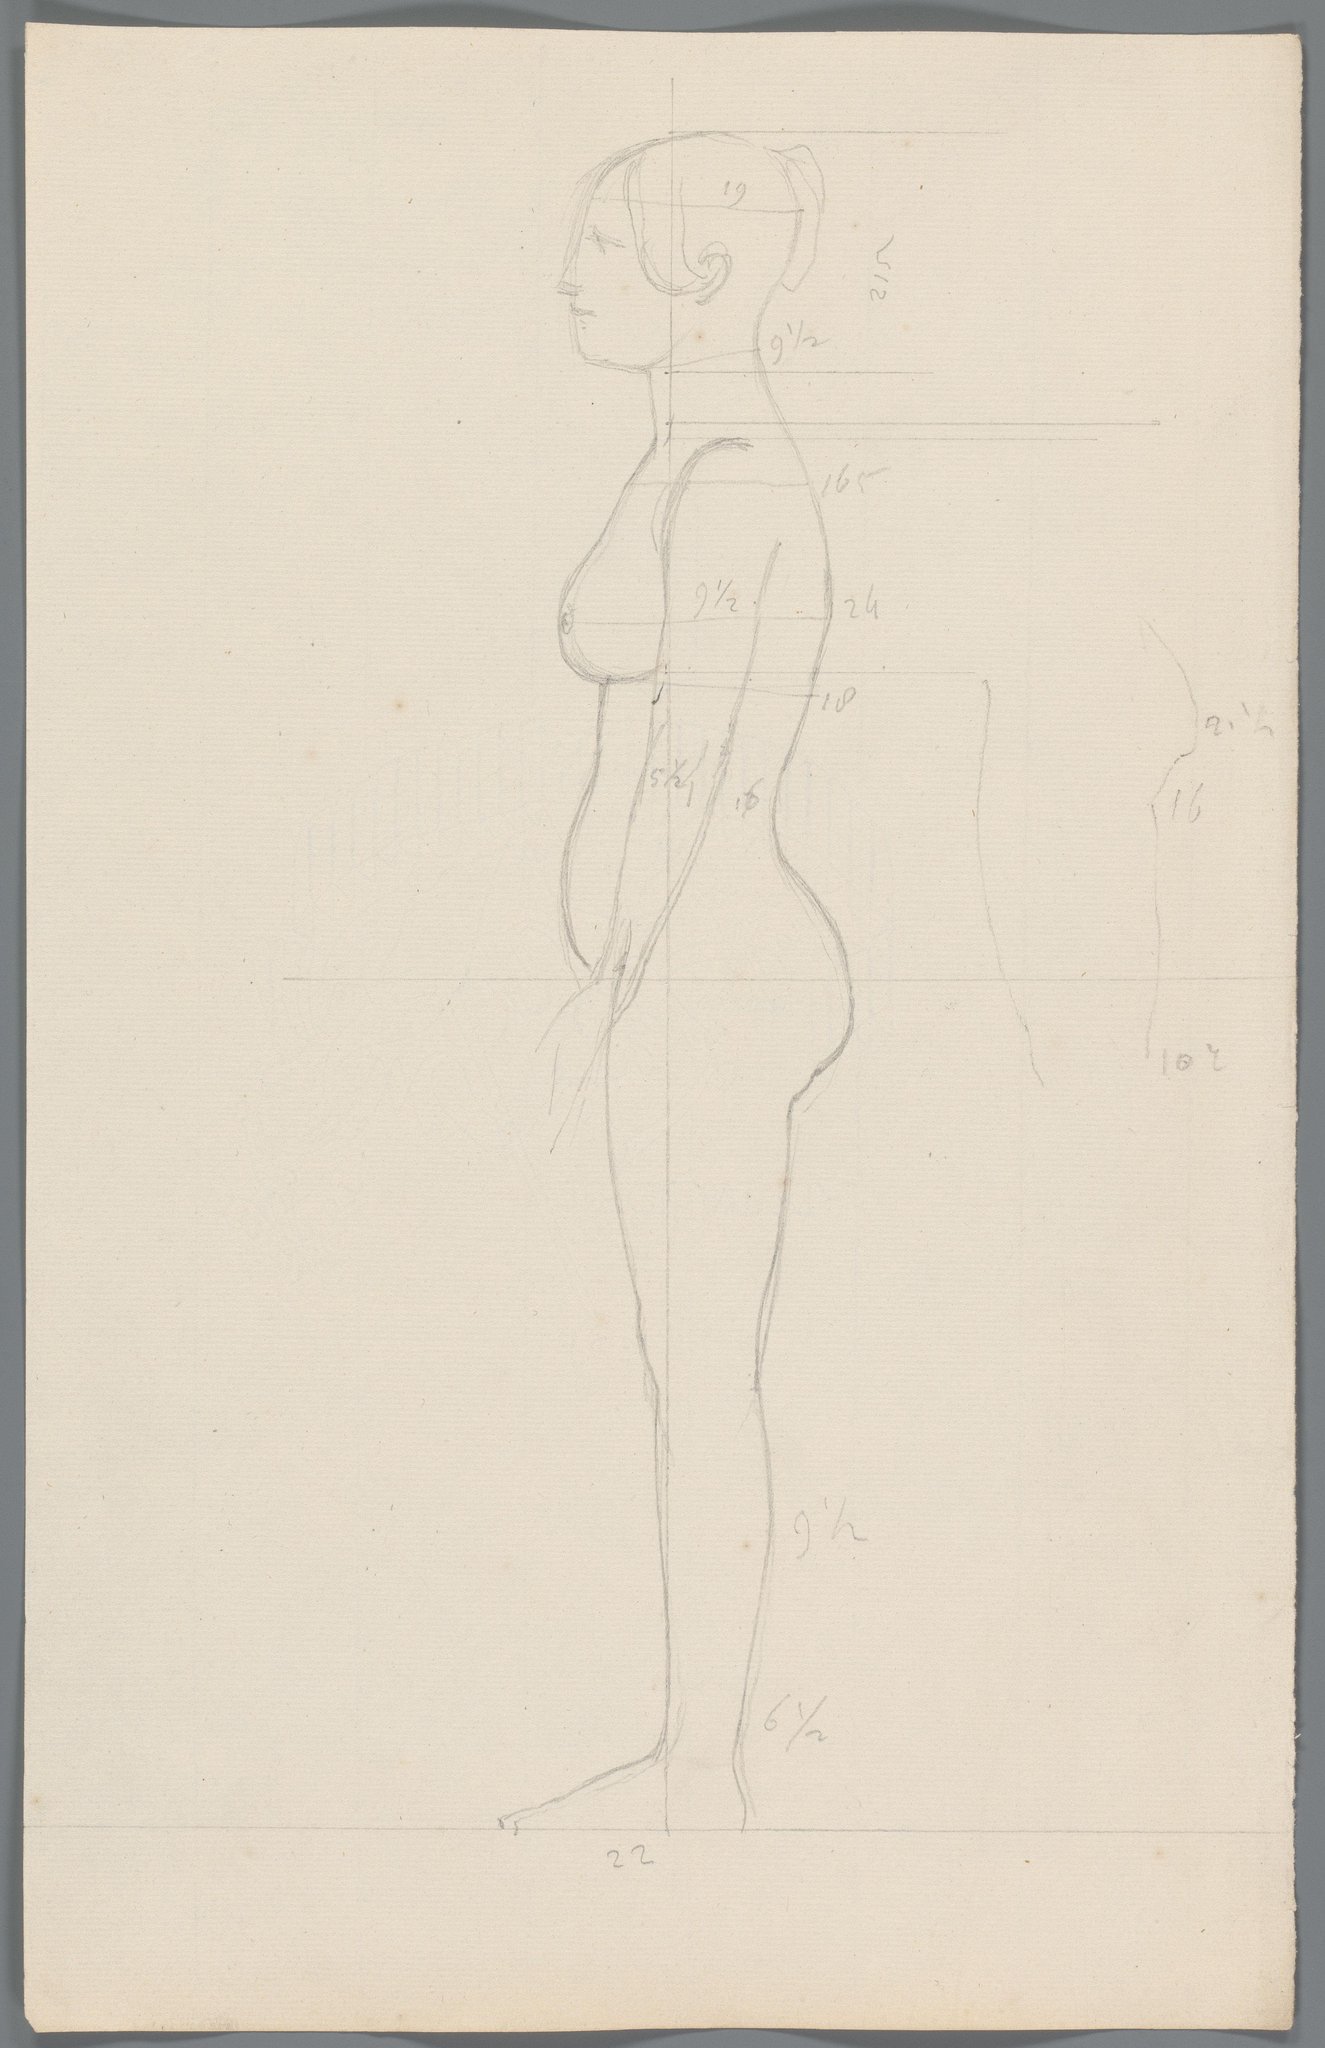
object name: drawing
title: Proportiestudie van een vrouw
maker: jacobus everhardus josephus van den berg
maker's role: draughtsman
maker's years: 1802-1861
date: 1812-1861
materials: paper, pencil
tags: standing figure (canon, proportions) - aa - female human figure, the (nude) human figure; 'corpo humano' (ripa) - aa - female human figure